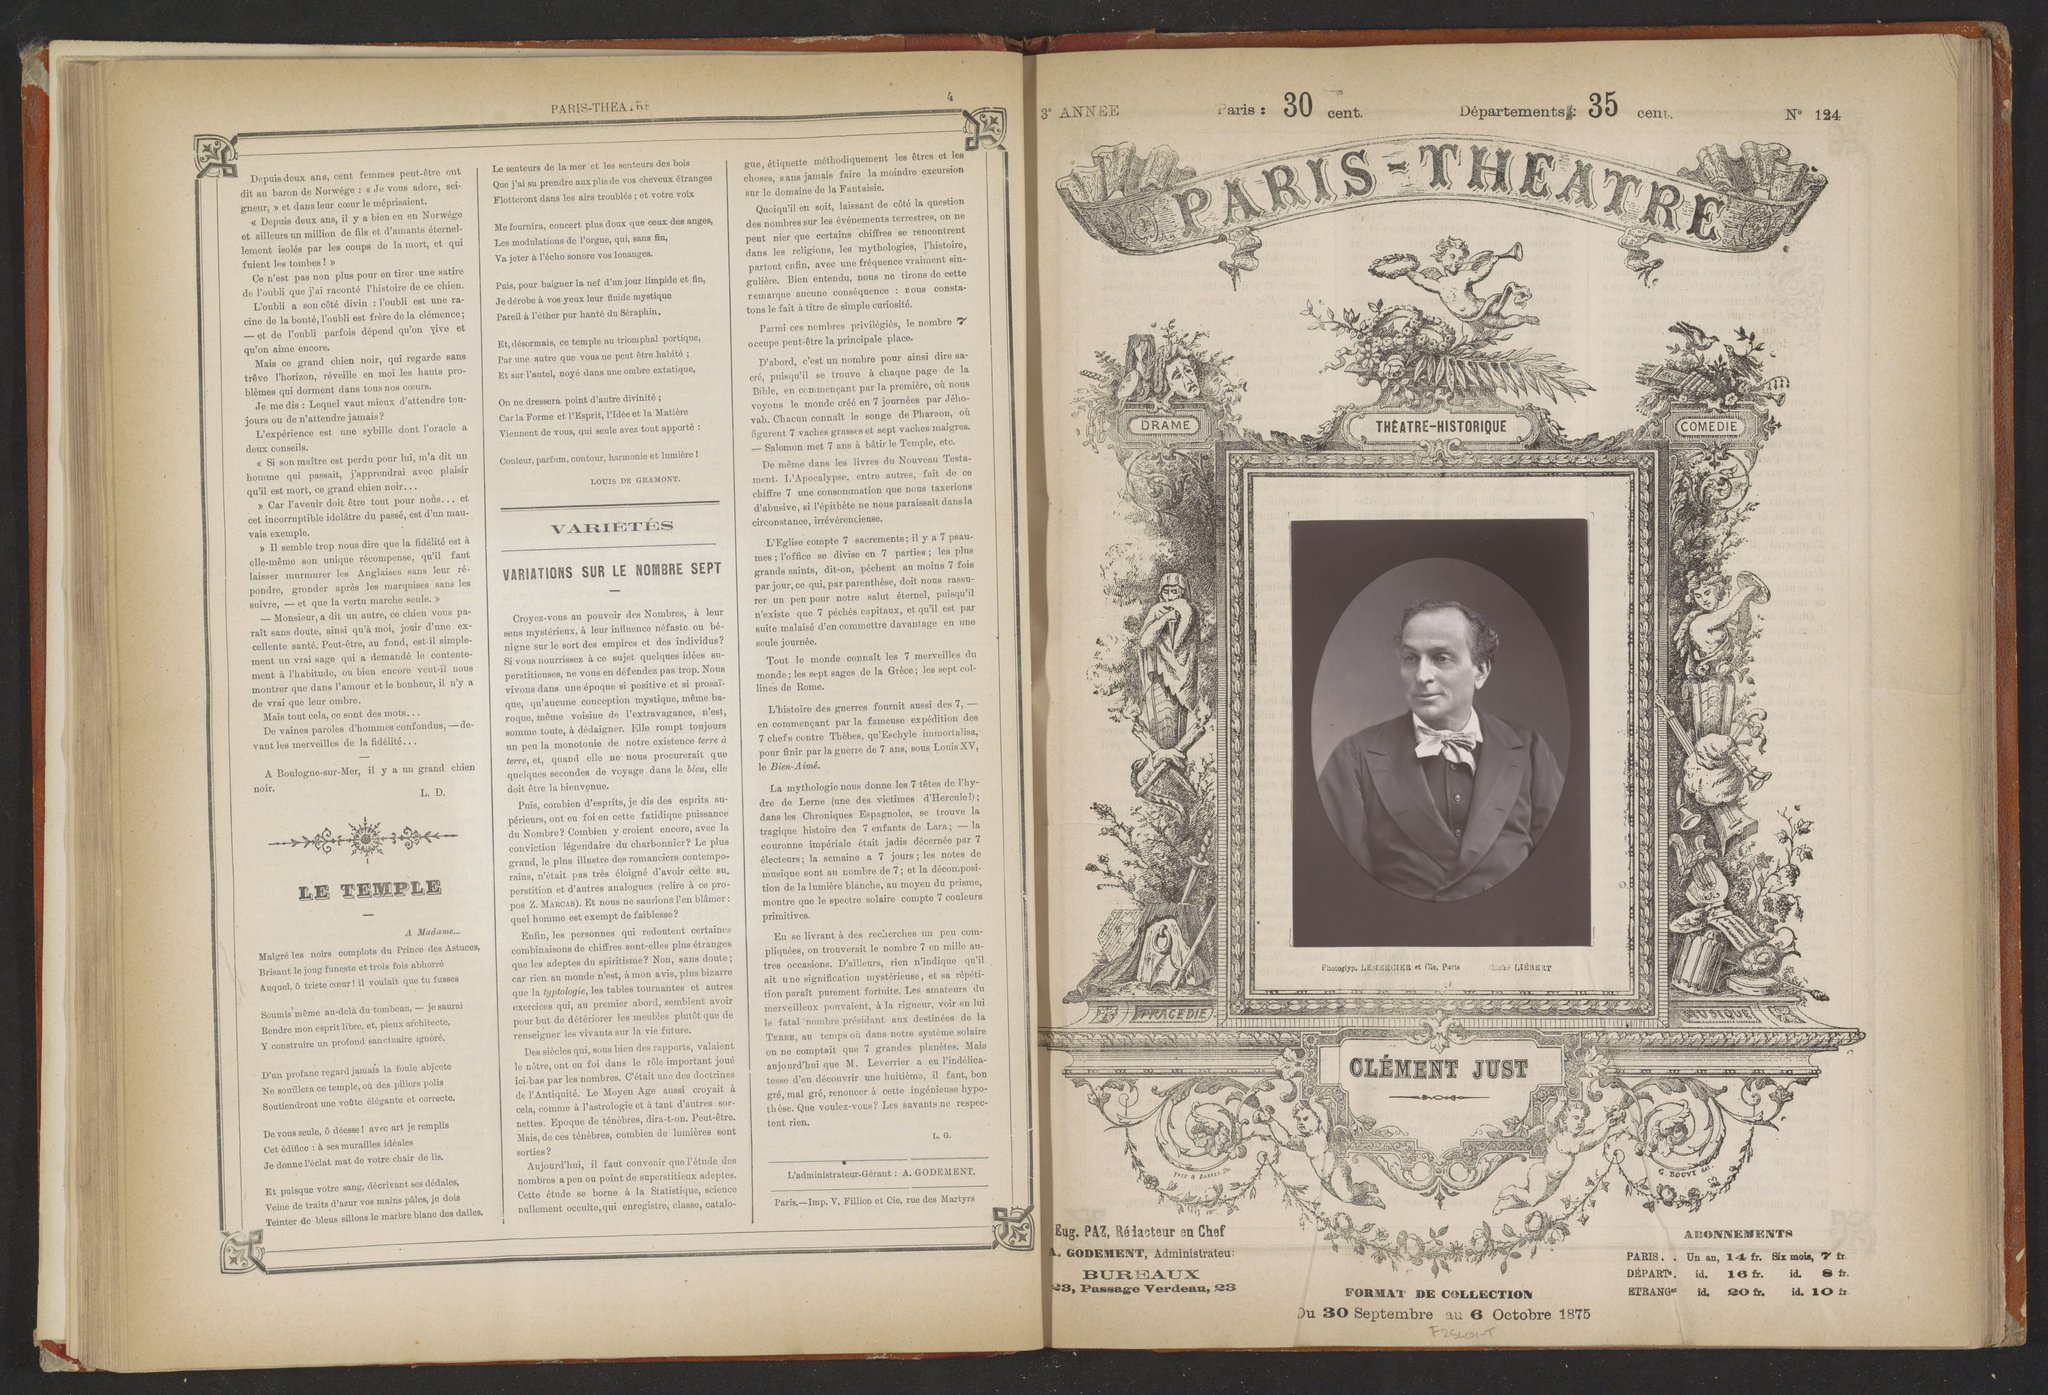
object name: photomechanical print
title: Clément Just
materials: paper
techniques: woodburytype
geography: france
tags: portrait of actor, actress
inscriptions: inscription: ‘Du 30 Septembre au 6 Octobre 1875’, number: ‘No 124’